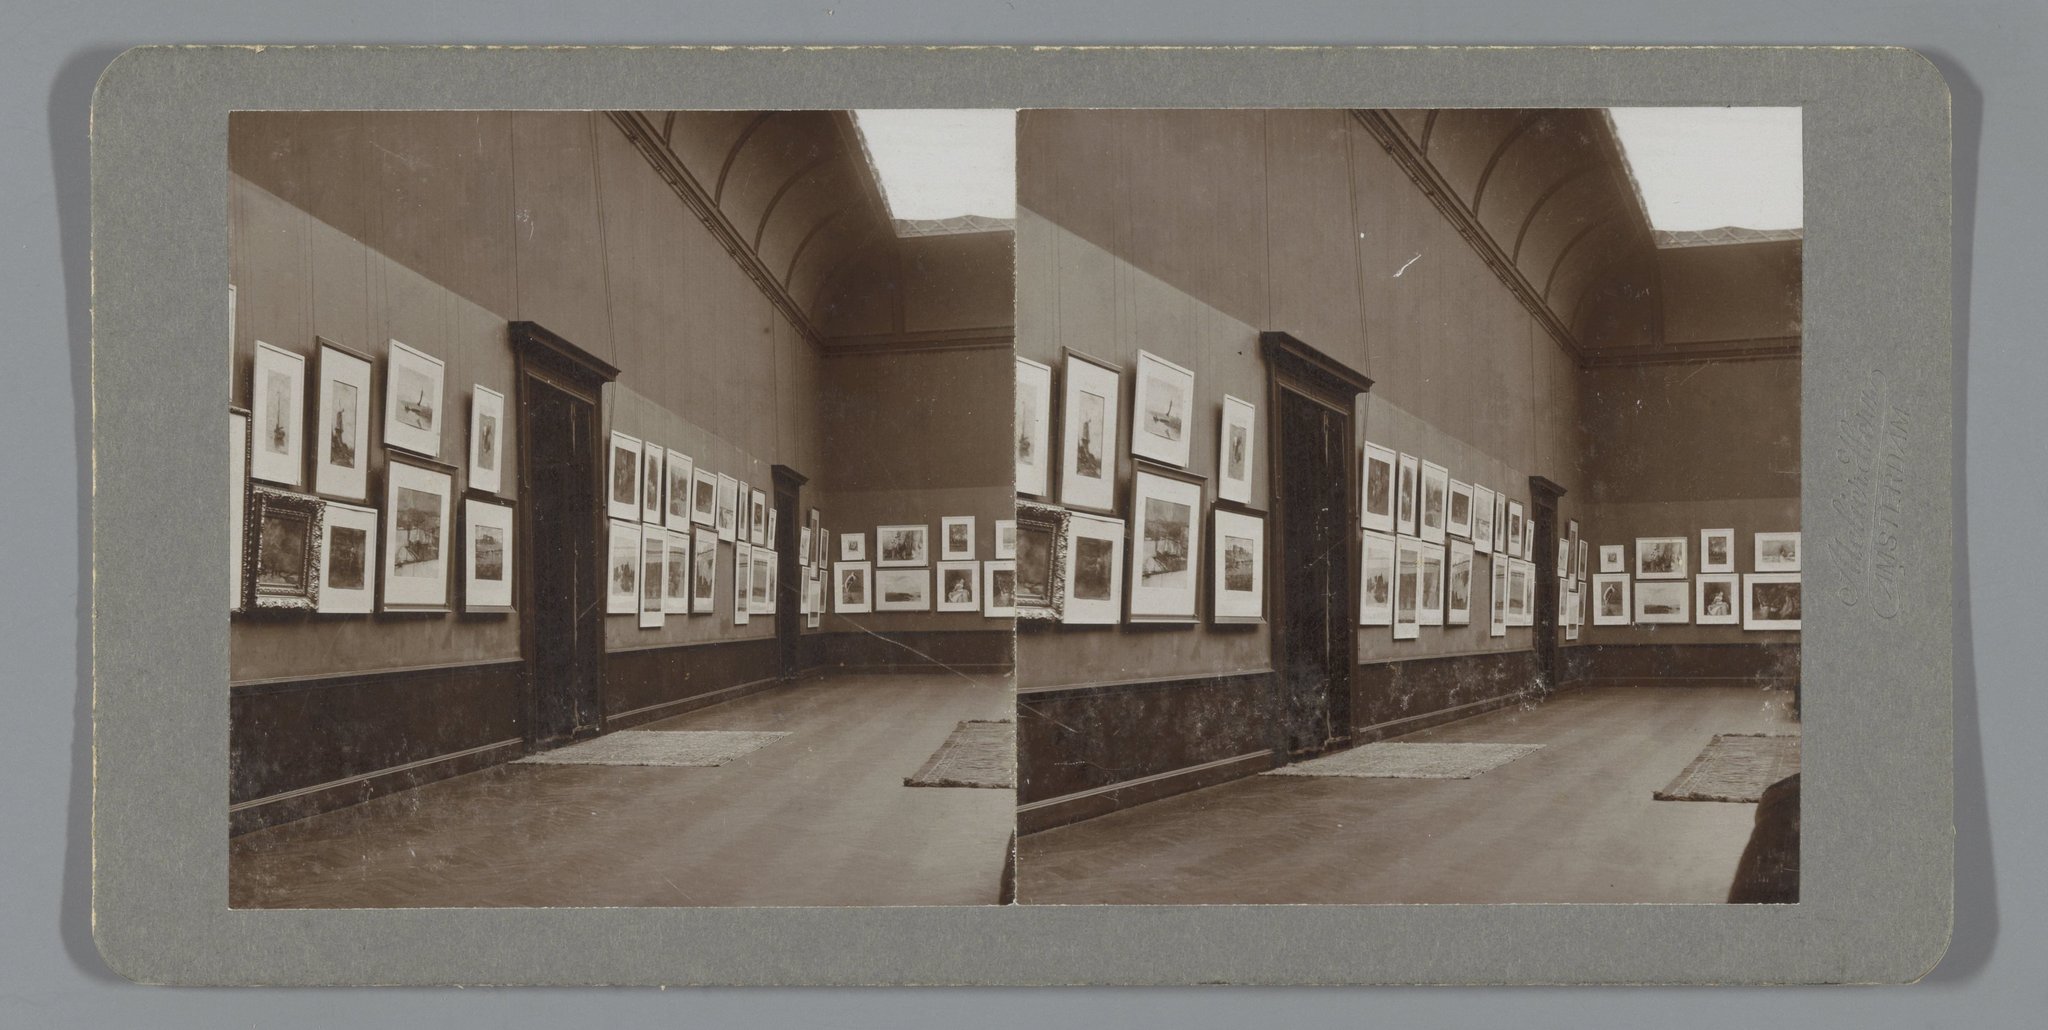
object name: stereograph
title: Gezicht in een zaal van het Stedelijk Museum, Amsterdam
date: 1902-1920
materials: paper, cardboard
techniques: gelatin silver print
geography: amsterdam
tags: collection, exhibition, show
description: Tijdens een tentoonstelling van de Vereeniging tot het Vormen van eene openbare verzameling van Hedendaagsche Kunst (VVHK, ook wel de 'vereeniging met de lange naam' genoemd).